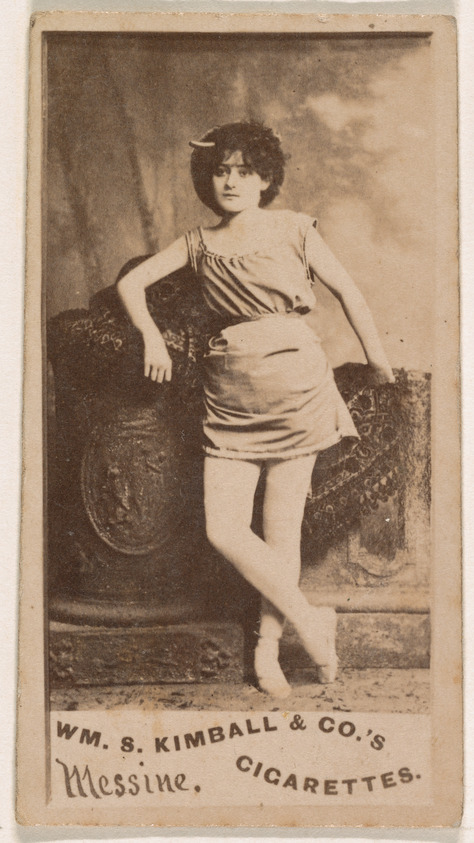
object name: photograph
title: Miss Messine, from the Actresses series (N203) issued by Wm. S. Kimball & Co.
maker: william s. kimball & company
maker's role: publisher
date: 1889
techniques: color lithograph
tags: portraits,women,actresses